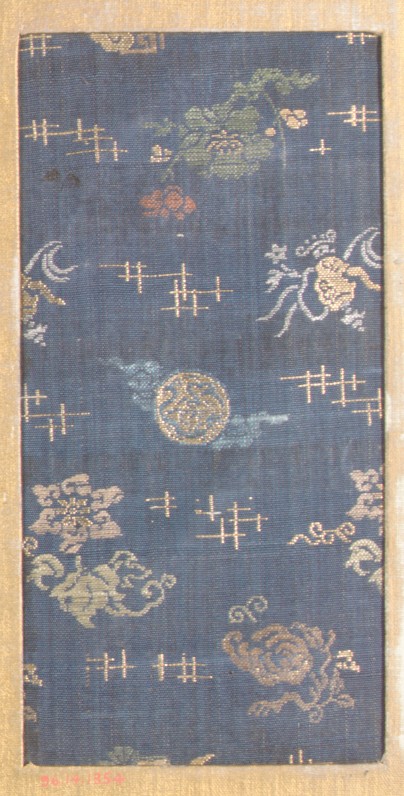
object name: piece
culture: japanese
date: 1701-1900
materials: silk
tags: flowers